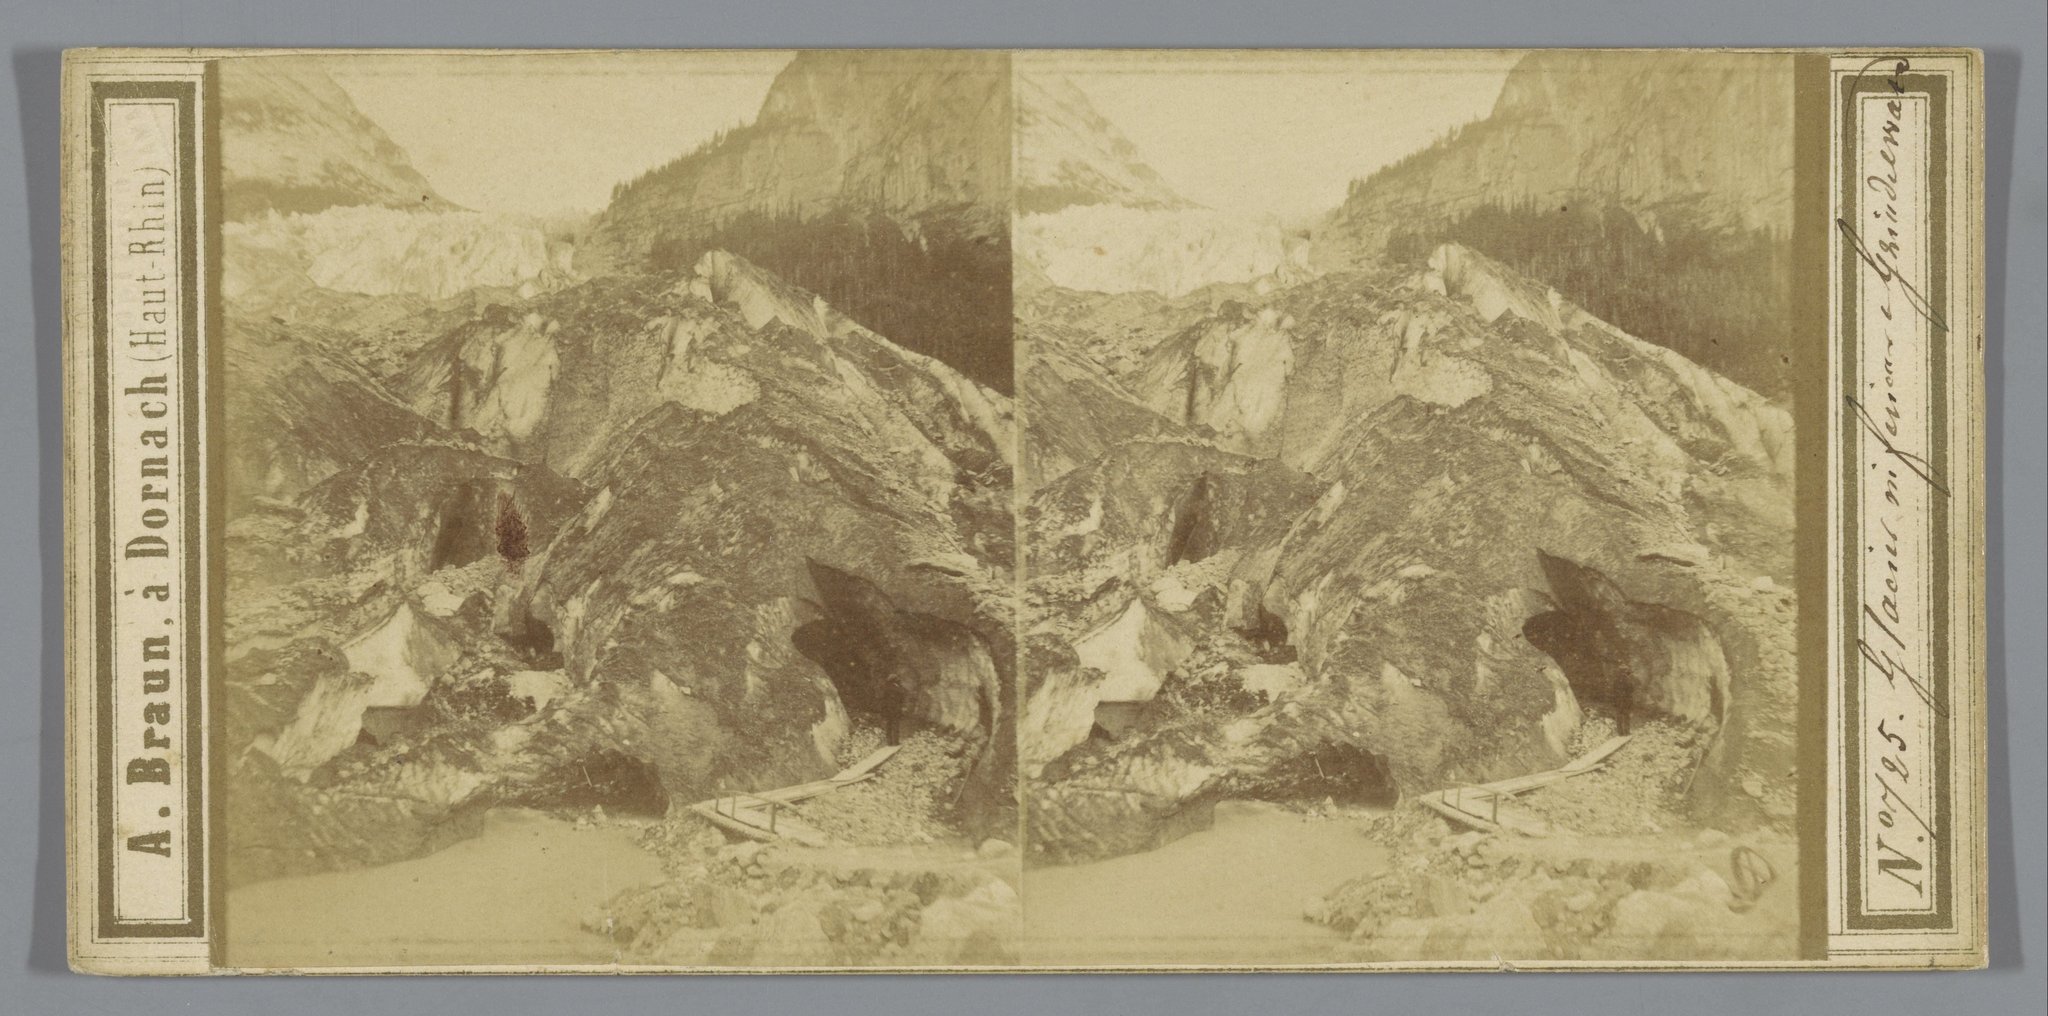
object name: stereograph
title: Glacier inferieur a Grindelwald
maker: Anonymous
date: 1860-1866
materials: cardboard, paper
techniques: albumen print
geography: dornach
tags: glacier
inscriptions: check stamp: ‘Louchet/ Opticien/ 44 passage panoramas’, inscription: ‘C F [?]’, number: ‘No. 725.’